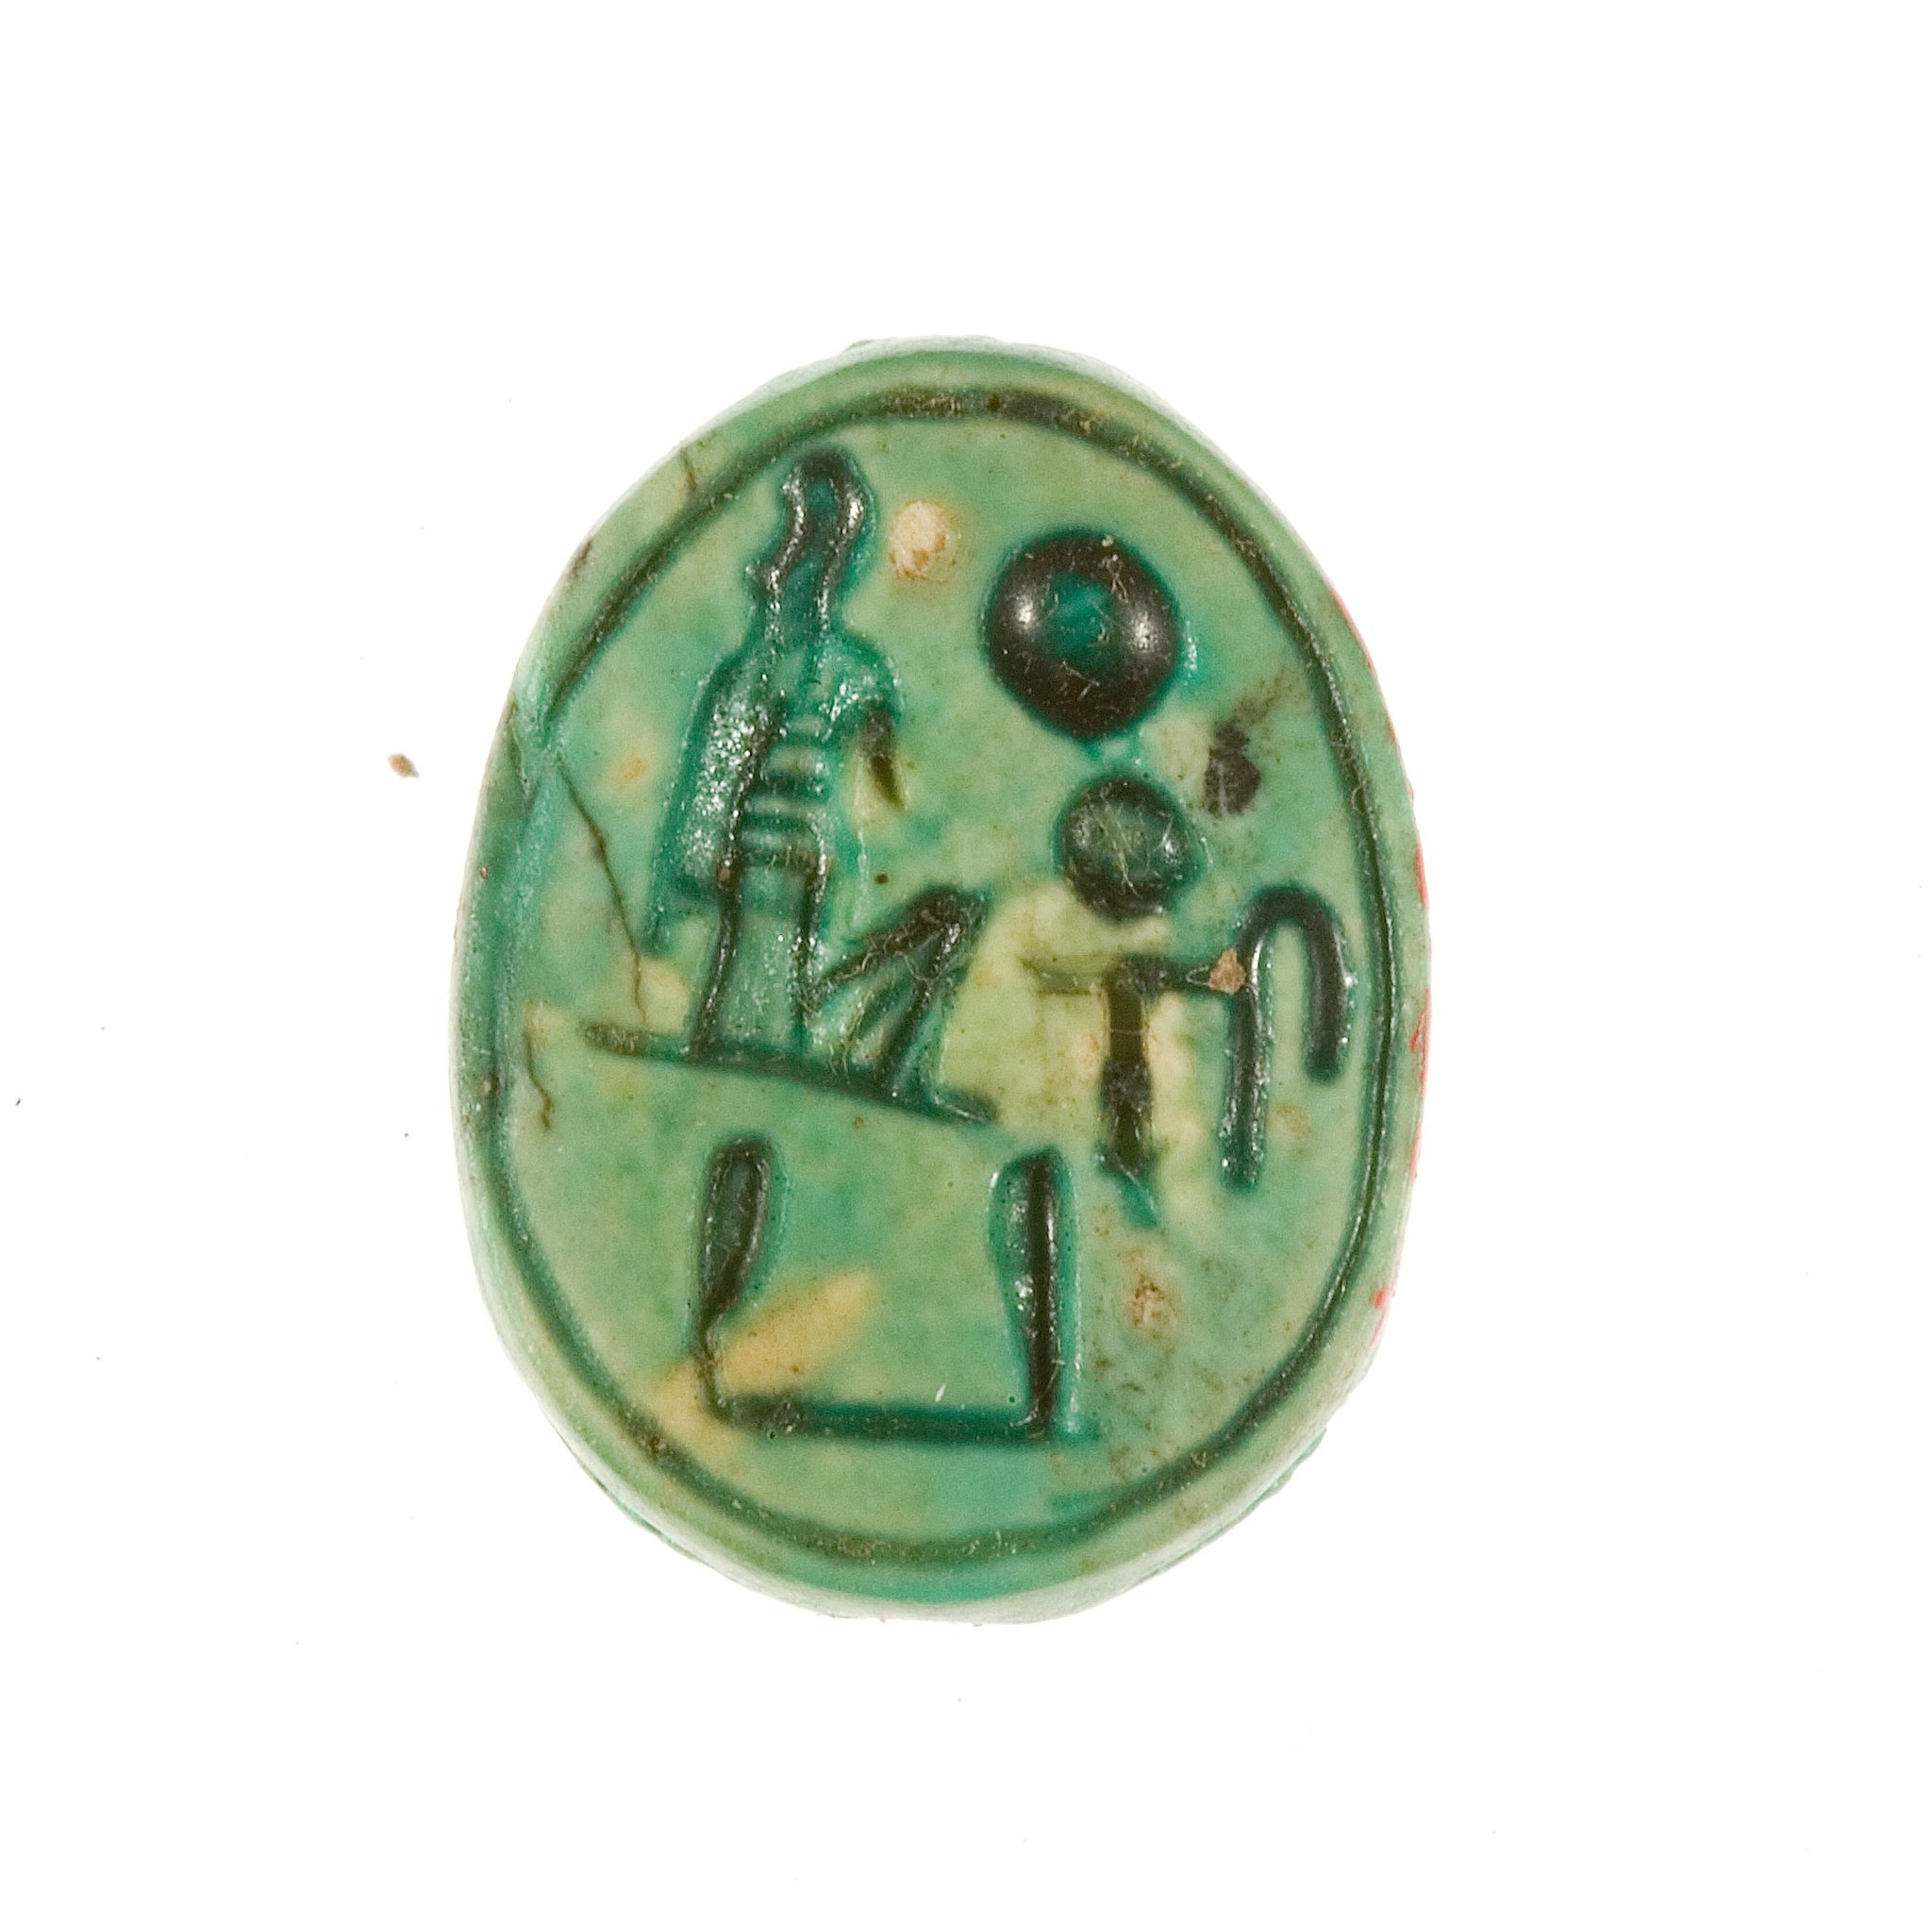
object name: scarab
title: Scarab Inscribed Maatkare (Hatshepsut), She Lives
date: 1479-1458 BCE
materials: stone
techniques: glazing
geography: egypt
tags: hieroglyphs,scarabs